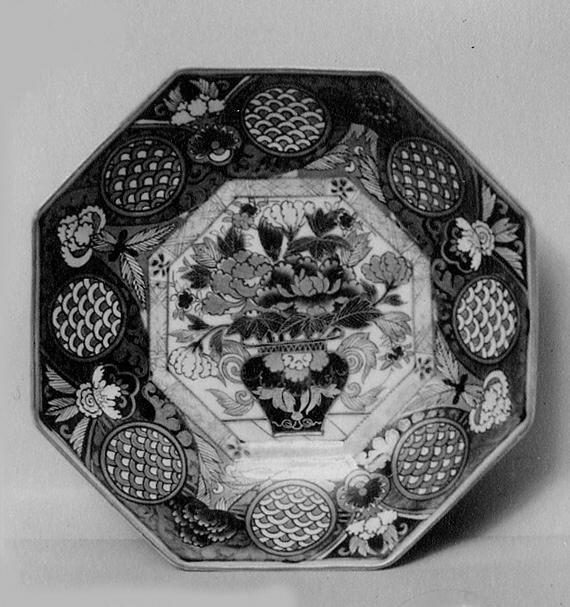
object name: plate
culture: japanese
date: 1750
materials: enamel, porcelain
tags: flowers,leaves